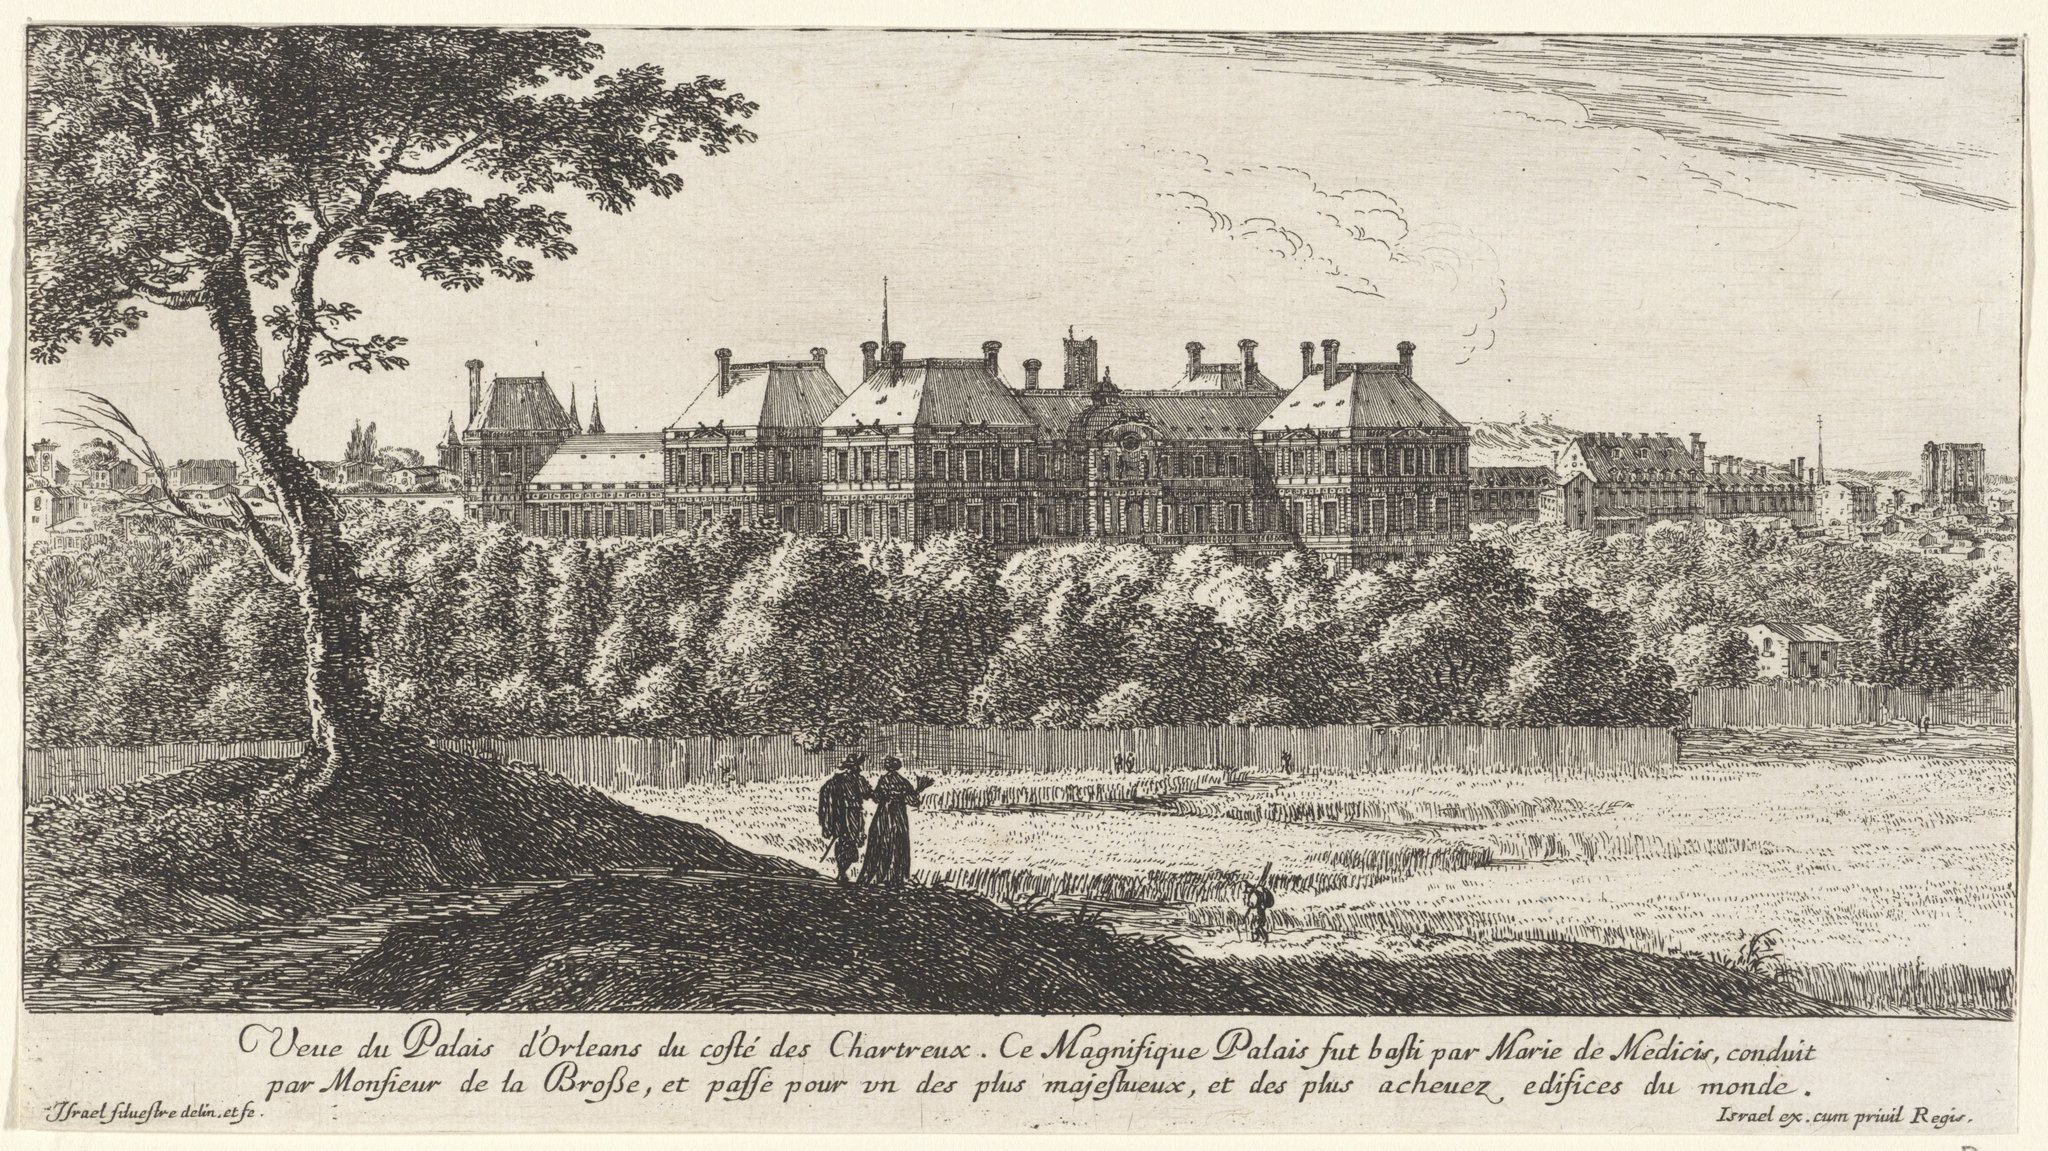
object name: print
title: Veue du Palais d'Orleans du costé des Chartreux (...)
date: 1650-1655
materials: paper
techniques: etching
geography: paris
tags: notre-dame, palais du luxembourg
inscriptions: collector's mark: Lugt 2228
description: Een man en een vrouw staan in de schaduw van een boom met op de achtergrond het Palais du Luxembourg (Palais d'Orléans). Onder de voorstelling staat een tweeregelige, Franse tekst met informatie over het Palais du Luxembourg.